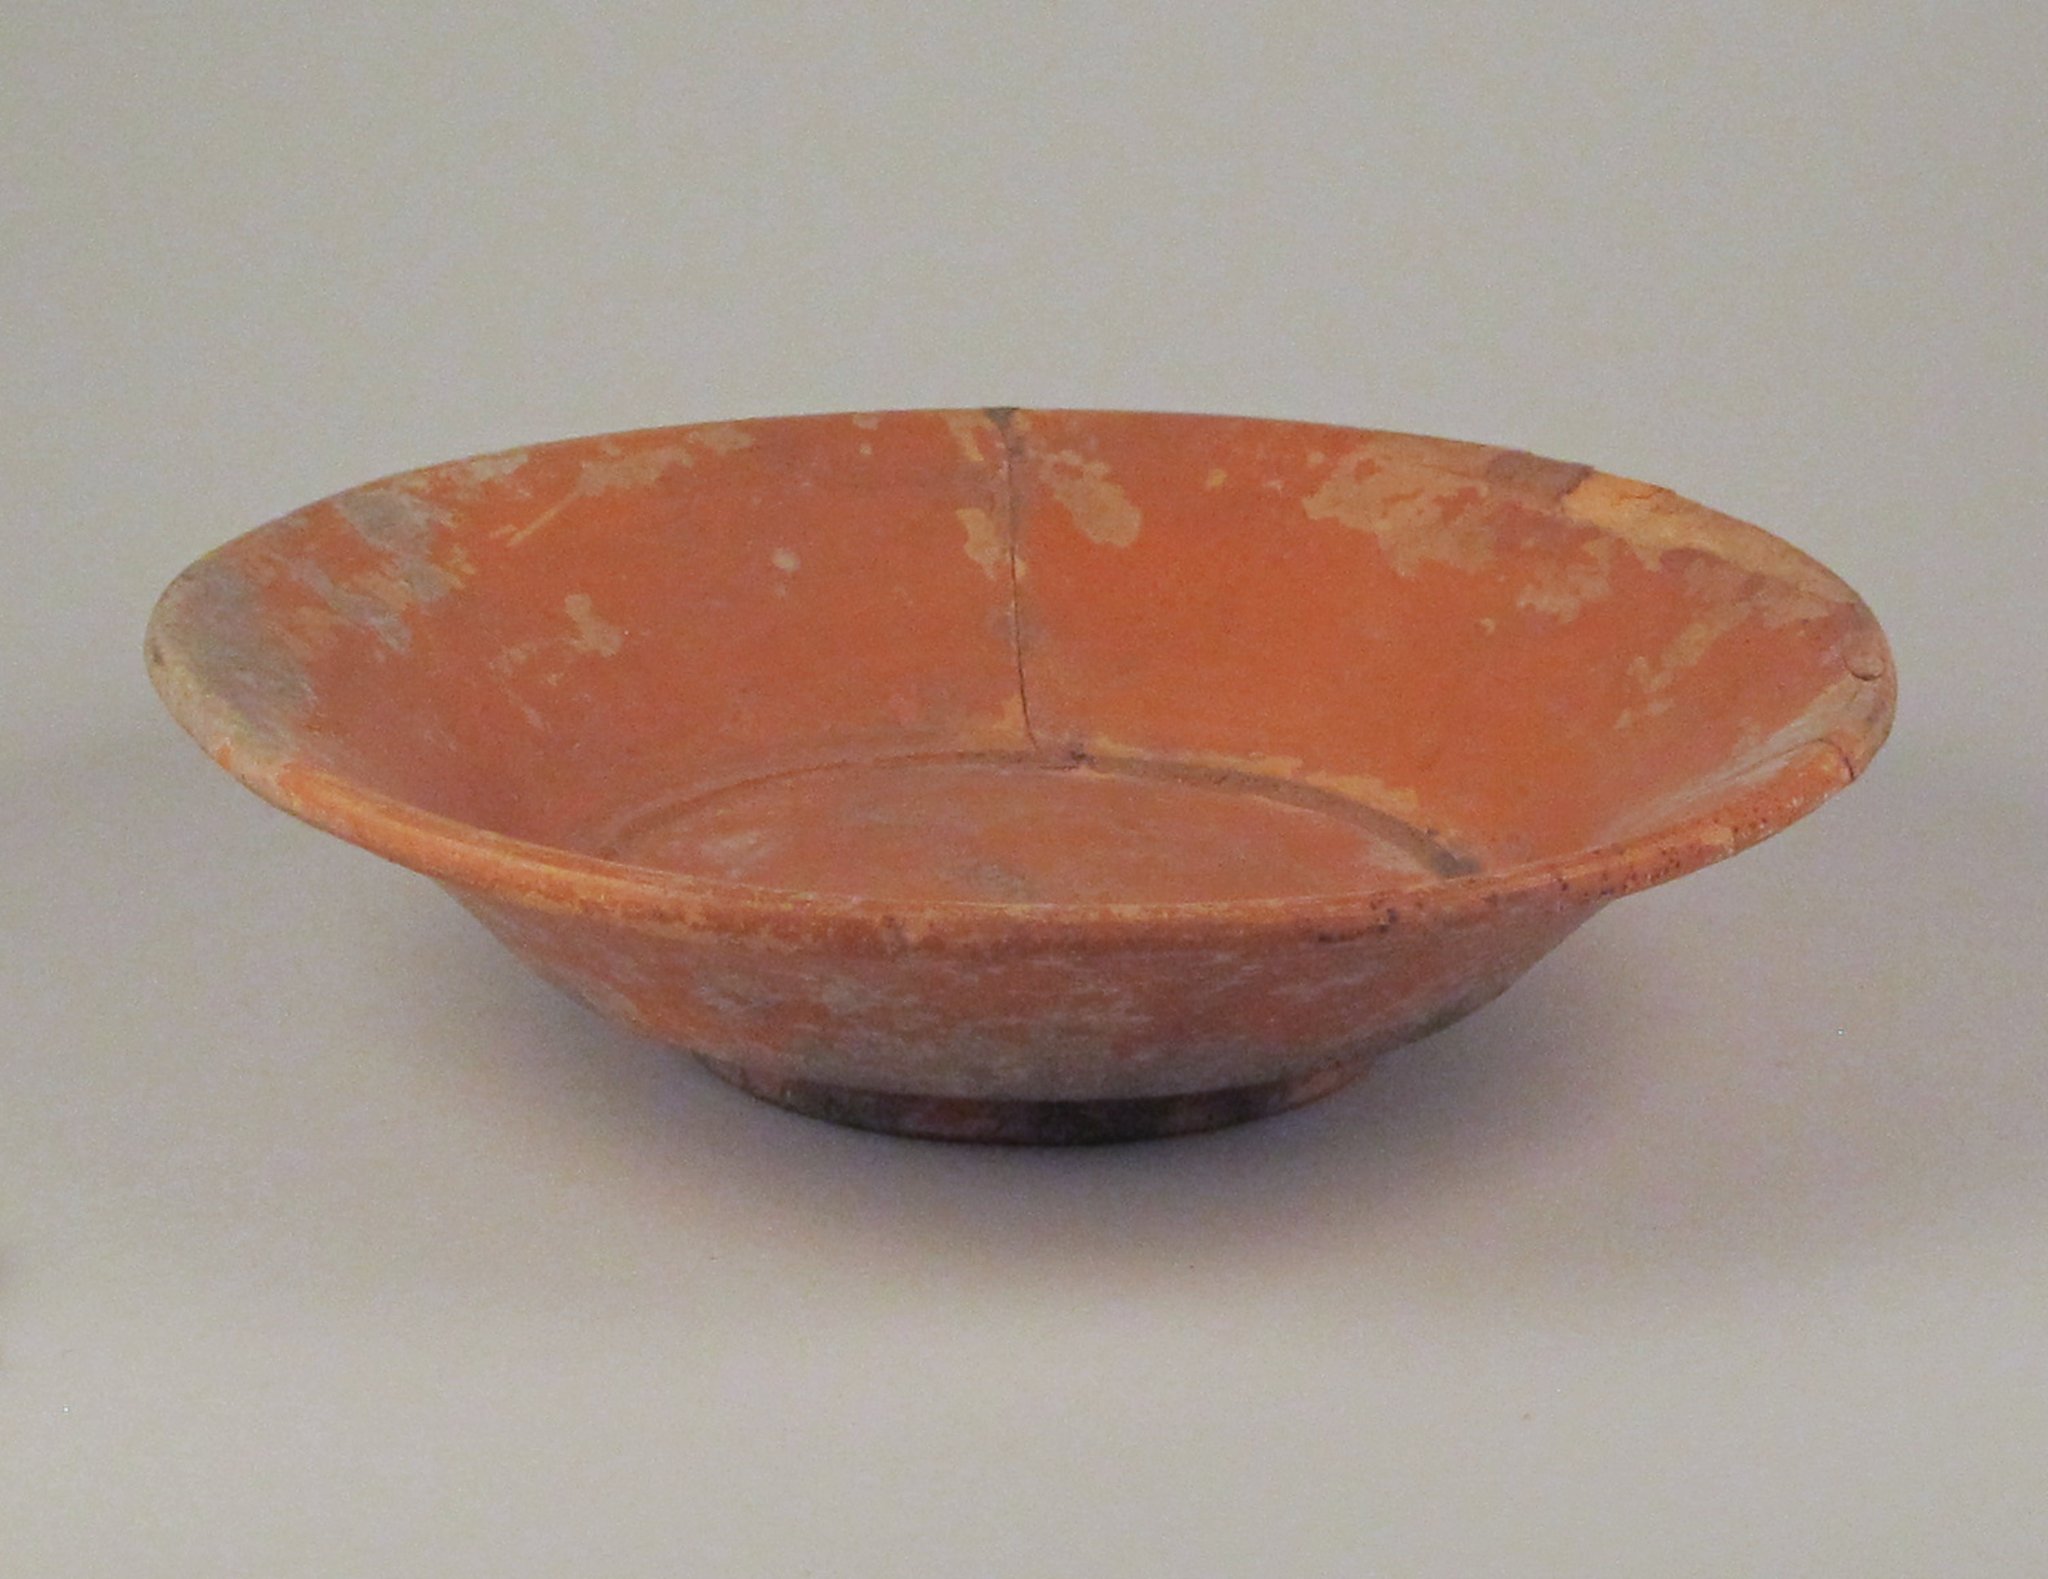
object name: plate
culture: roman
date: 670 BCE-330 CE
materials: terracotta